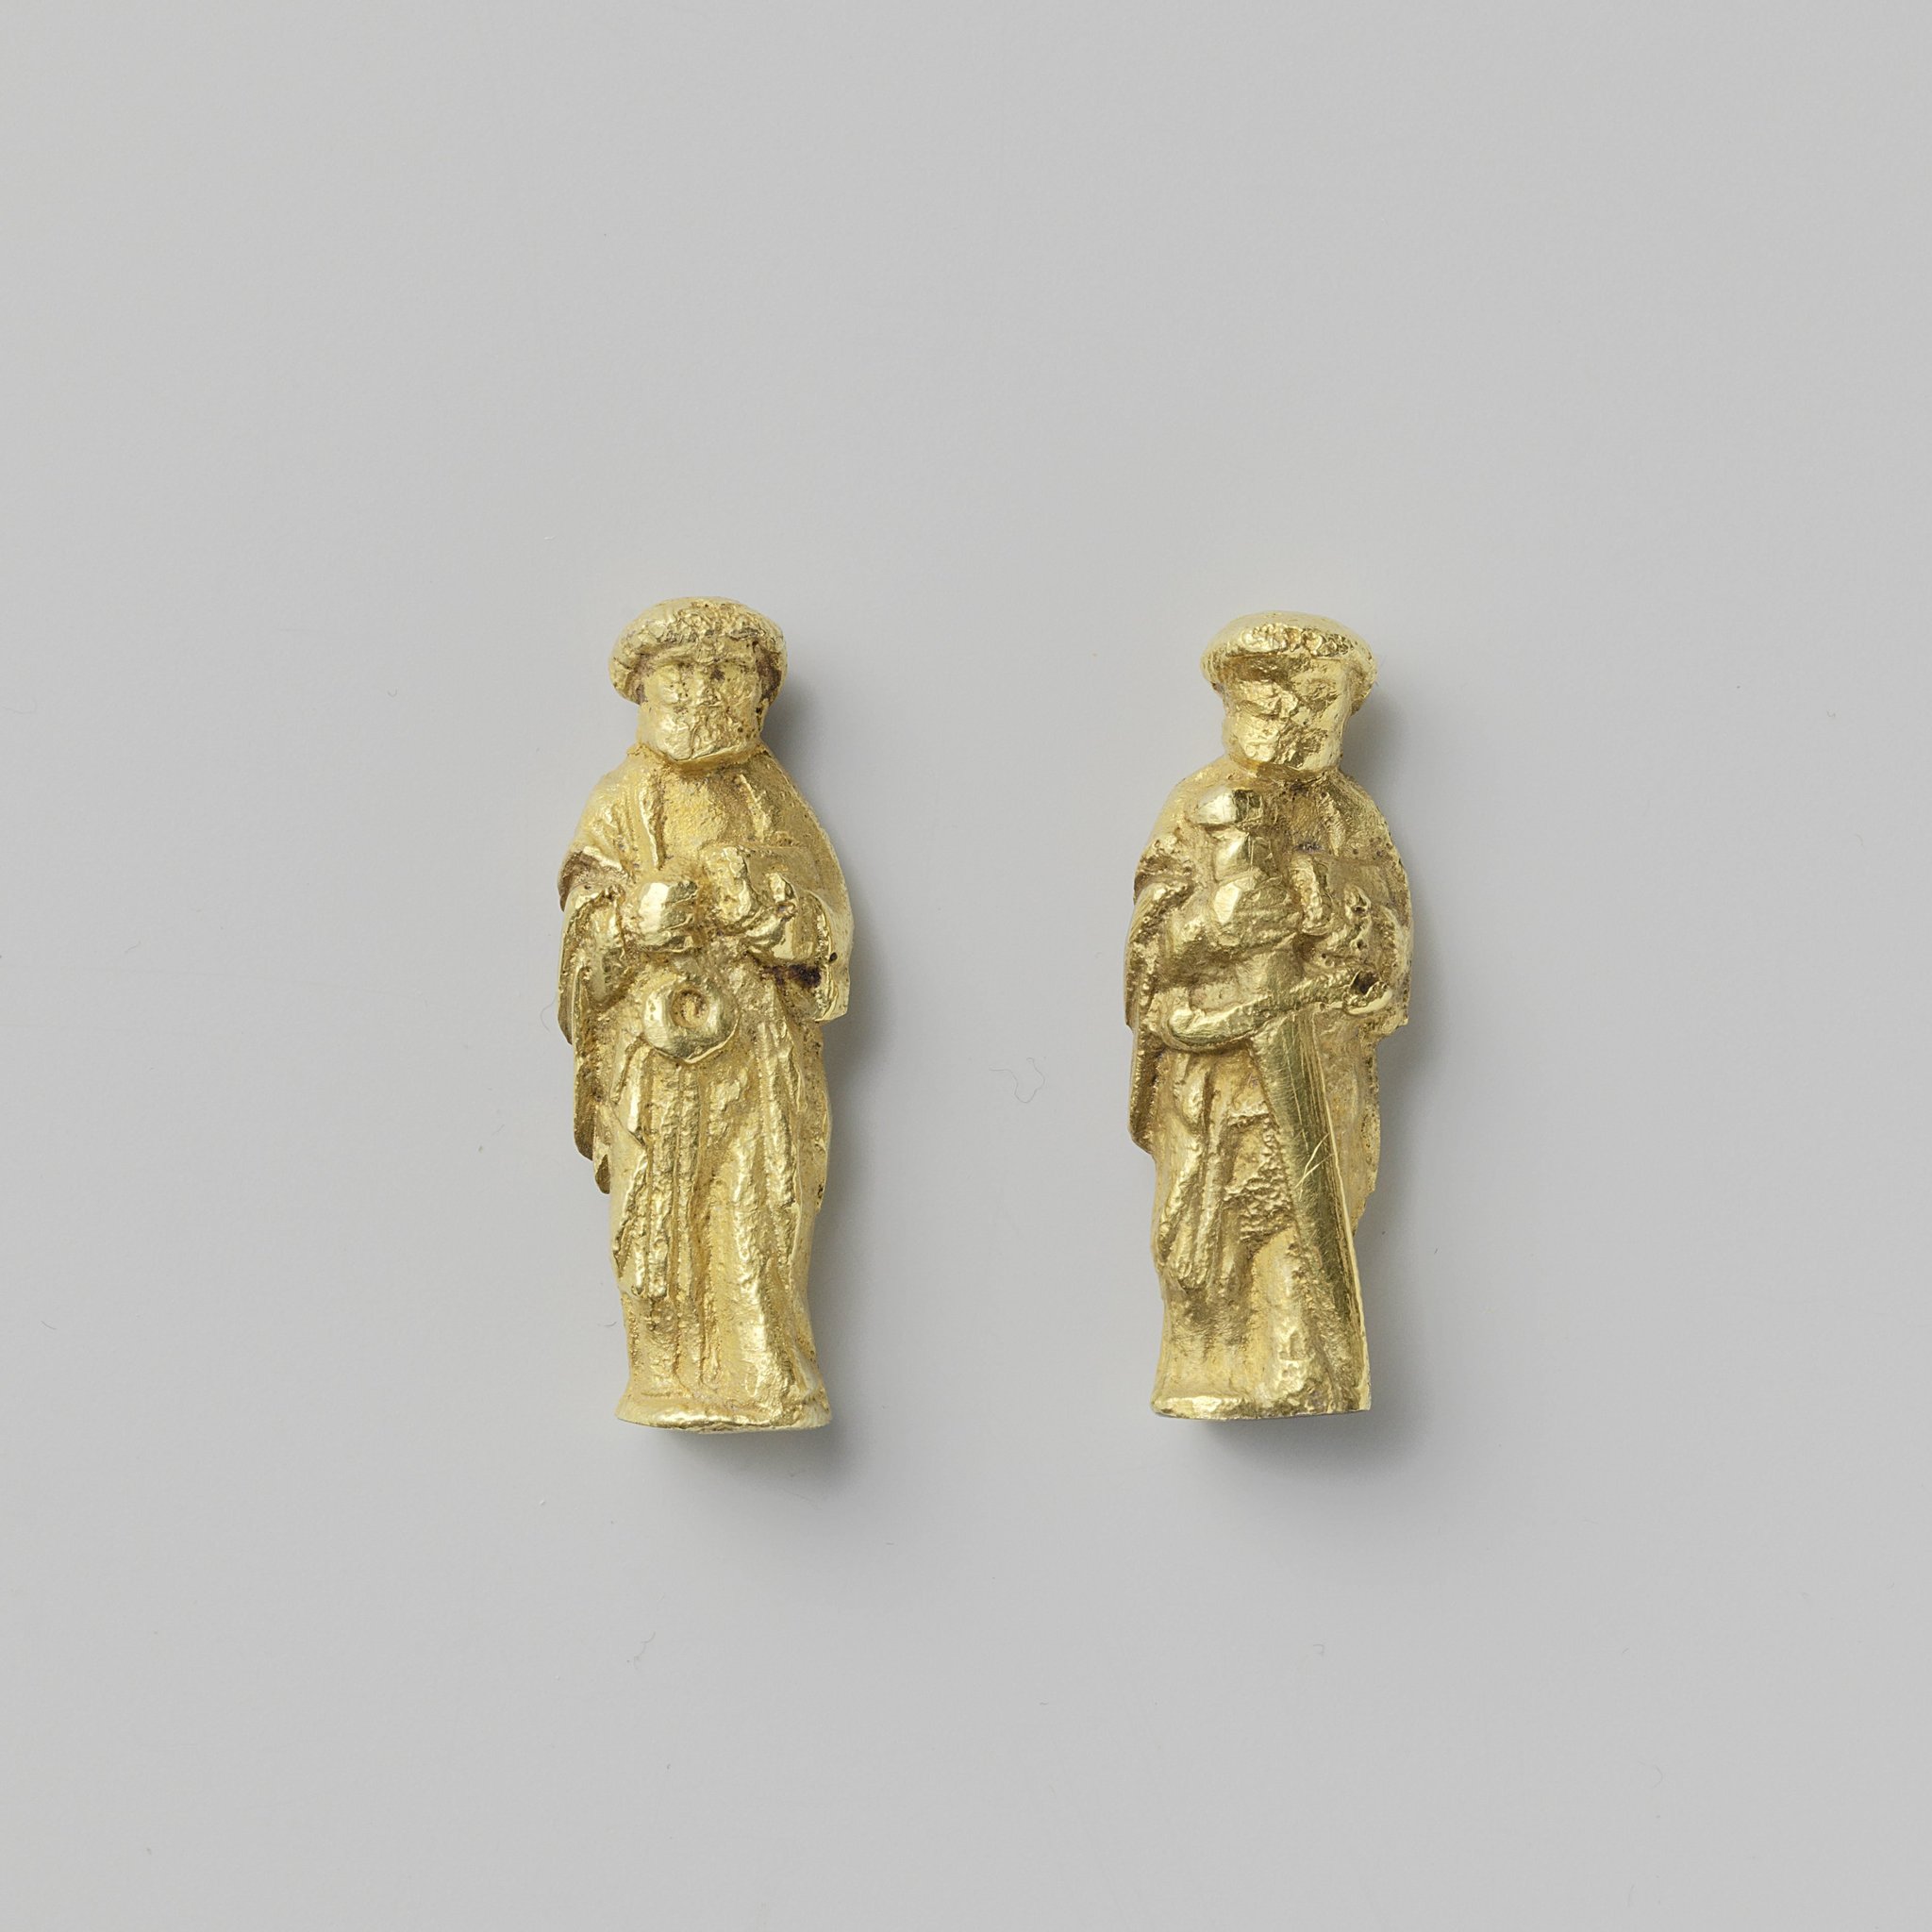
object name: monstrans, ostensorium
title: Monstrance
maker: jan geldolfs hoghenzoon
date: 1520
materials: silver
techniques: gilding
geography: breda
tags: 'marianum', madonna in aureole or mandorla (surrounded by the rosary), mary in the glory, the apostle peter, first bishop of rome; possible attributes: book, cock, (upturned) cross, (triple) crozier, fish, key, scroll, ship, tiara, the apostle paul of tarsus; possible attributes: book, scroll, sword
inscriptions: maker's mark: ‘G’, town mark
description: Twee heiligenfiguren (waarschijnlijk niet origineel) afkomstig van de Bredase monstrans (BK-1981-2).